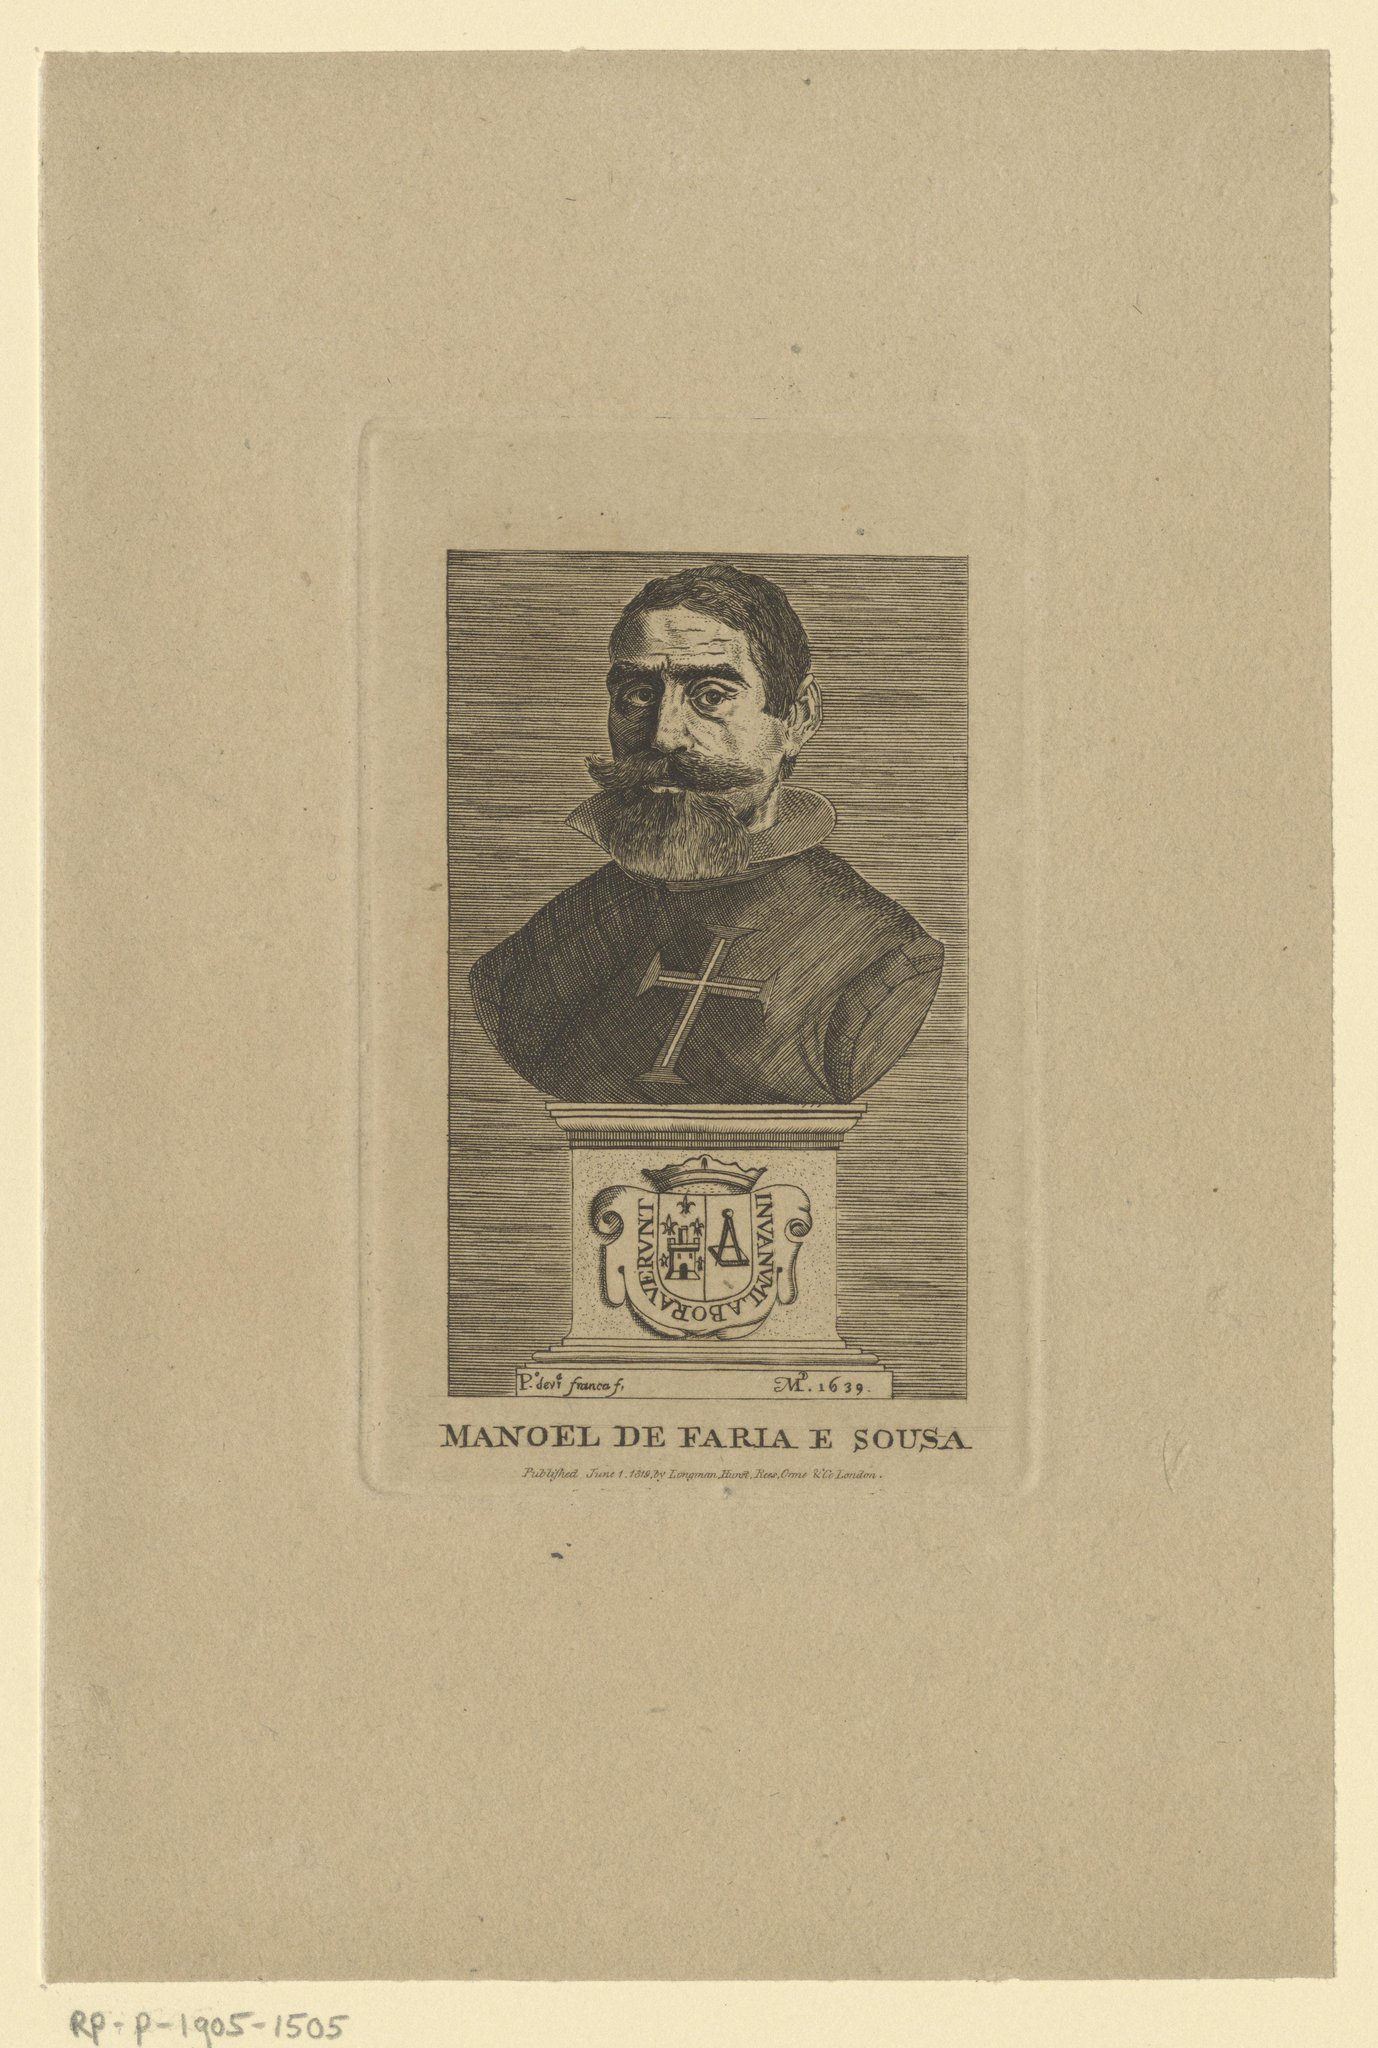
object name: print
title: Portretbuste van Manuel de Faria e Sousa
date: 1806-1819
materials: paper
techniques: engraving, etching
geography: london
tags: historical persons, armorial bearing, heraldry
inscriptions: collector's mark: Lugt 2228